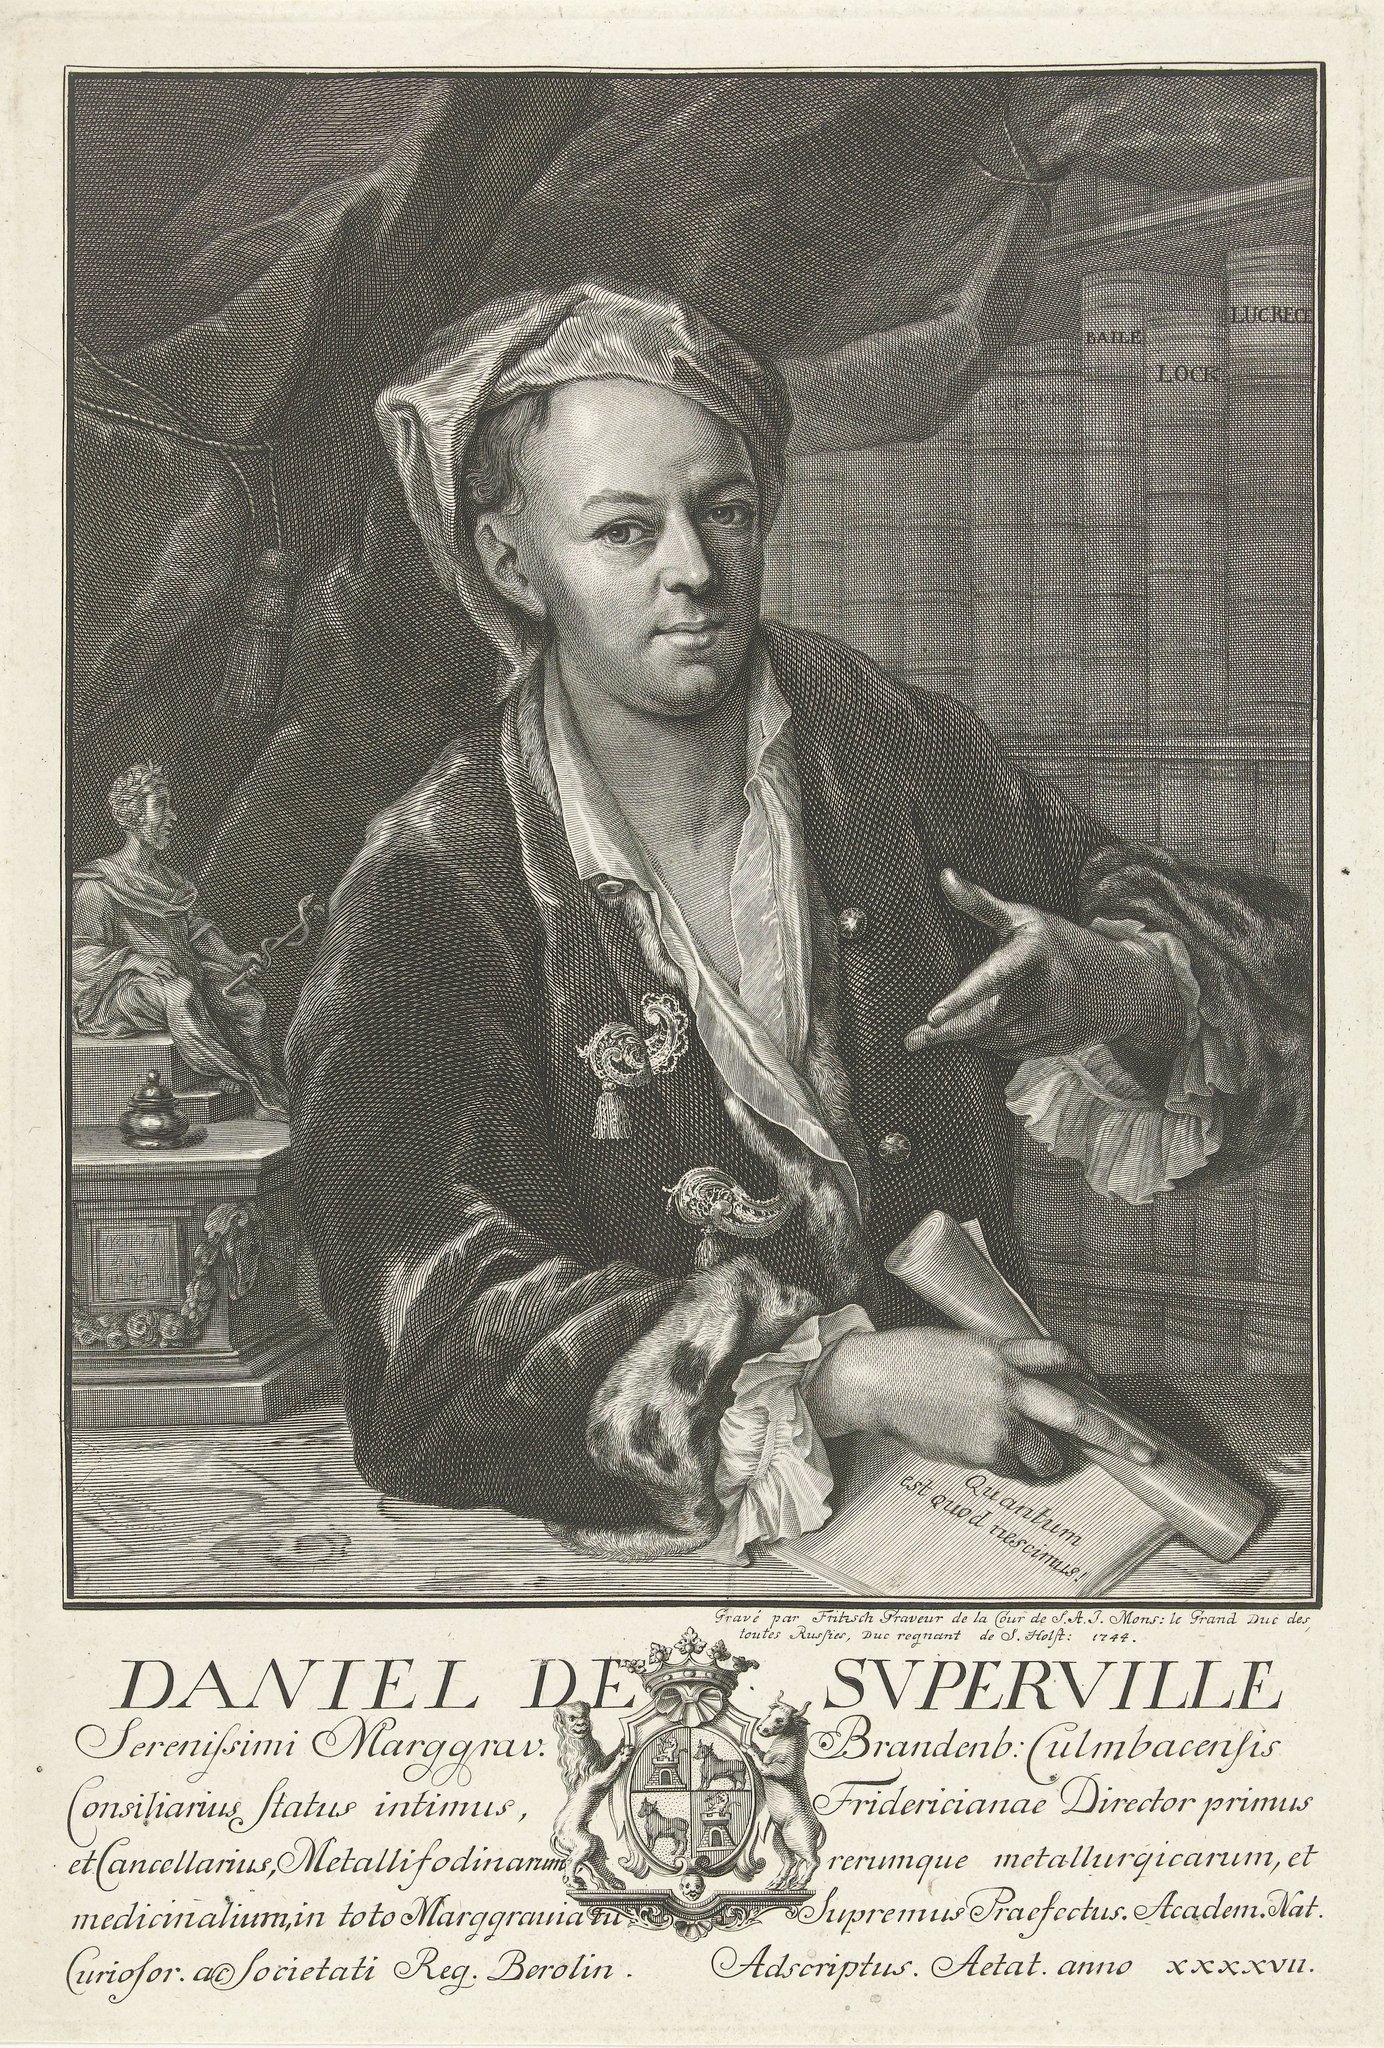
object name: print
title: Portret van Daniel de Superville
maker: christian friedrich fritzsch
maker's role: print maker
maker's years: 1719-1774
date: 1744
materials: paper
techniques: engraving, etching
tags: rotterdam, aesculapius as patron of medicine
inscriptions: collector's mark: Lugt 2228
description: De arts Daniel de Superville in zijn bibliotheek, ten halven lijve, gekleed in een kamerjas, om zijn hoofd een doek gedrapeerd. In zijn rechterhand houdt hij een rol papier vast met de tekst: Quantum est quod nescimus. Links naast hem staat een beeldje van Aesculapius, de god van de gezondheid en geneeskunst, met in zijn handen de esculaap en aan zijn voeten een zalfpot. In de marge onder het portret staat de naam van de geportretterde, gevolgd door een zesregelige tekst. Centraal in het midden van de marge is een gekroond wapenschild geflankeerd door een leeuw en een rund weergegeven.